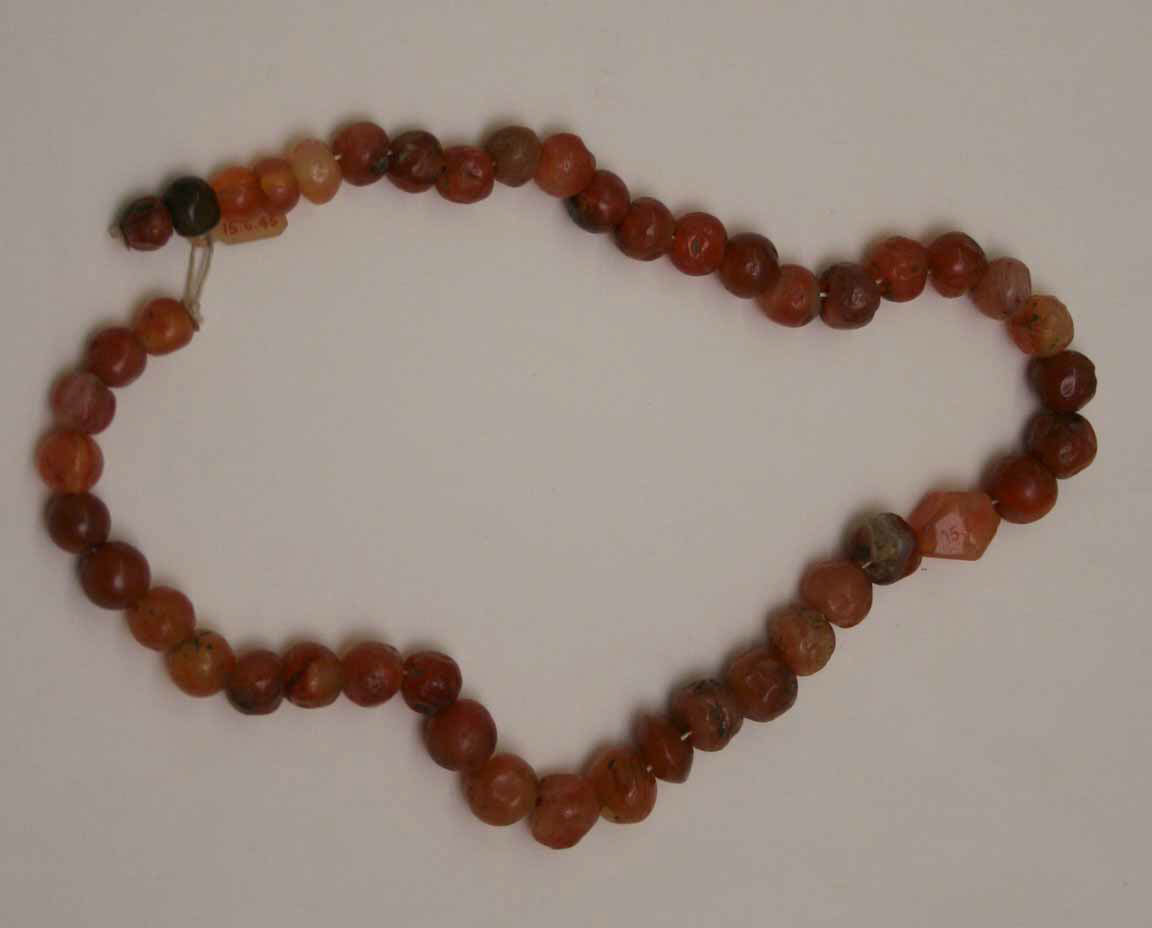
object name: bead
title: Beads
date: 501-1200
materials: amber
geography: egypt